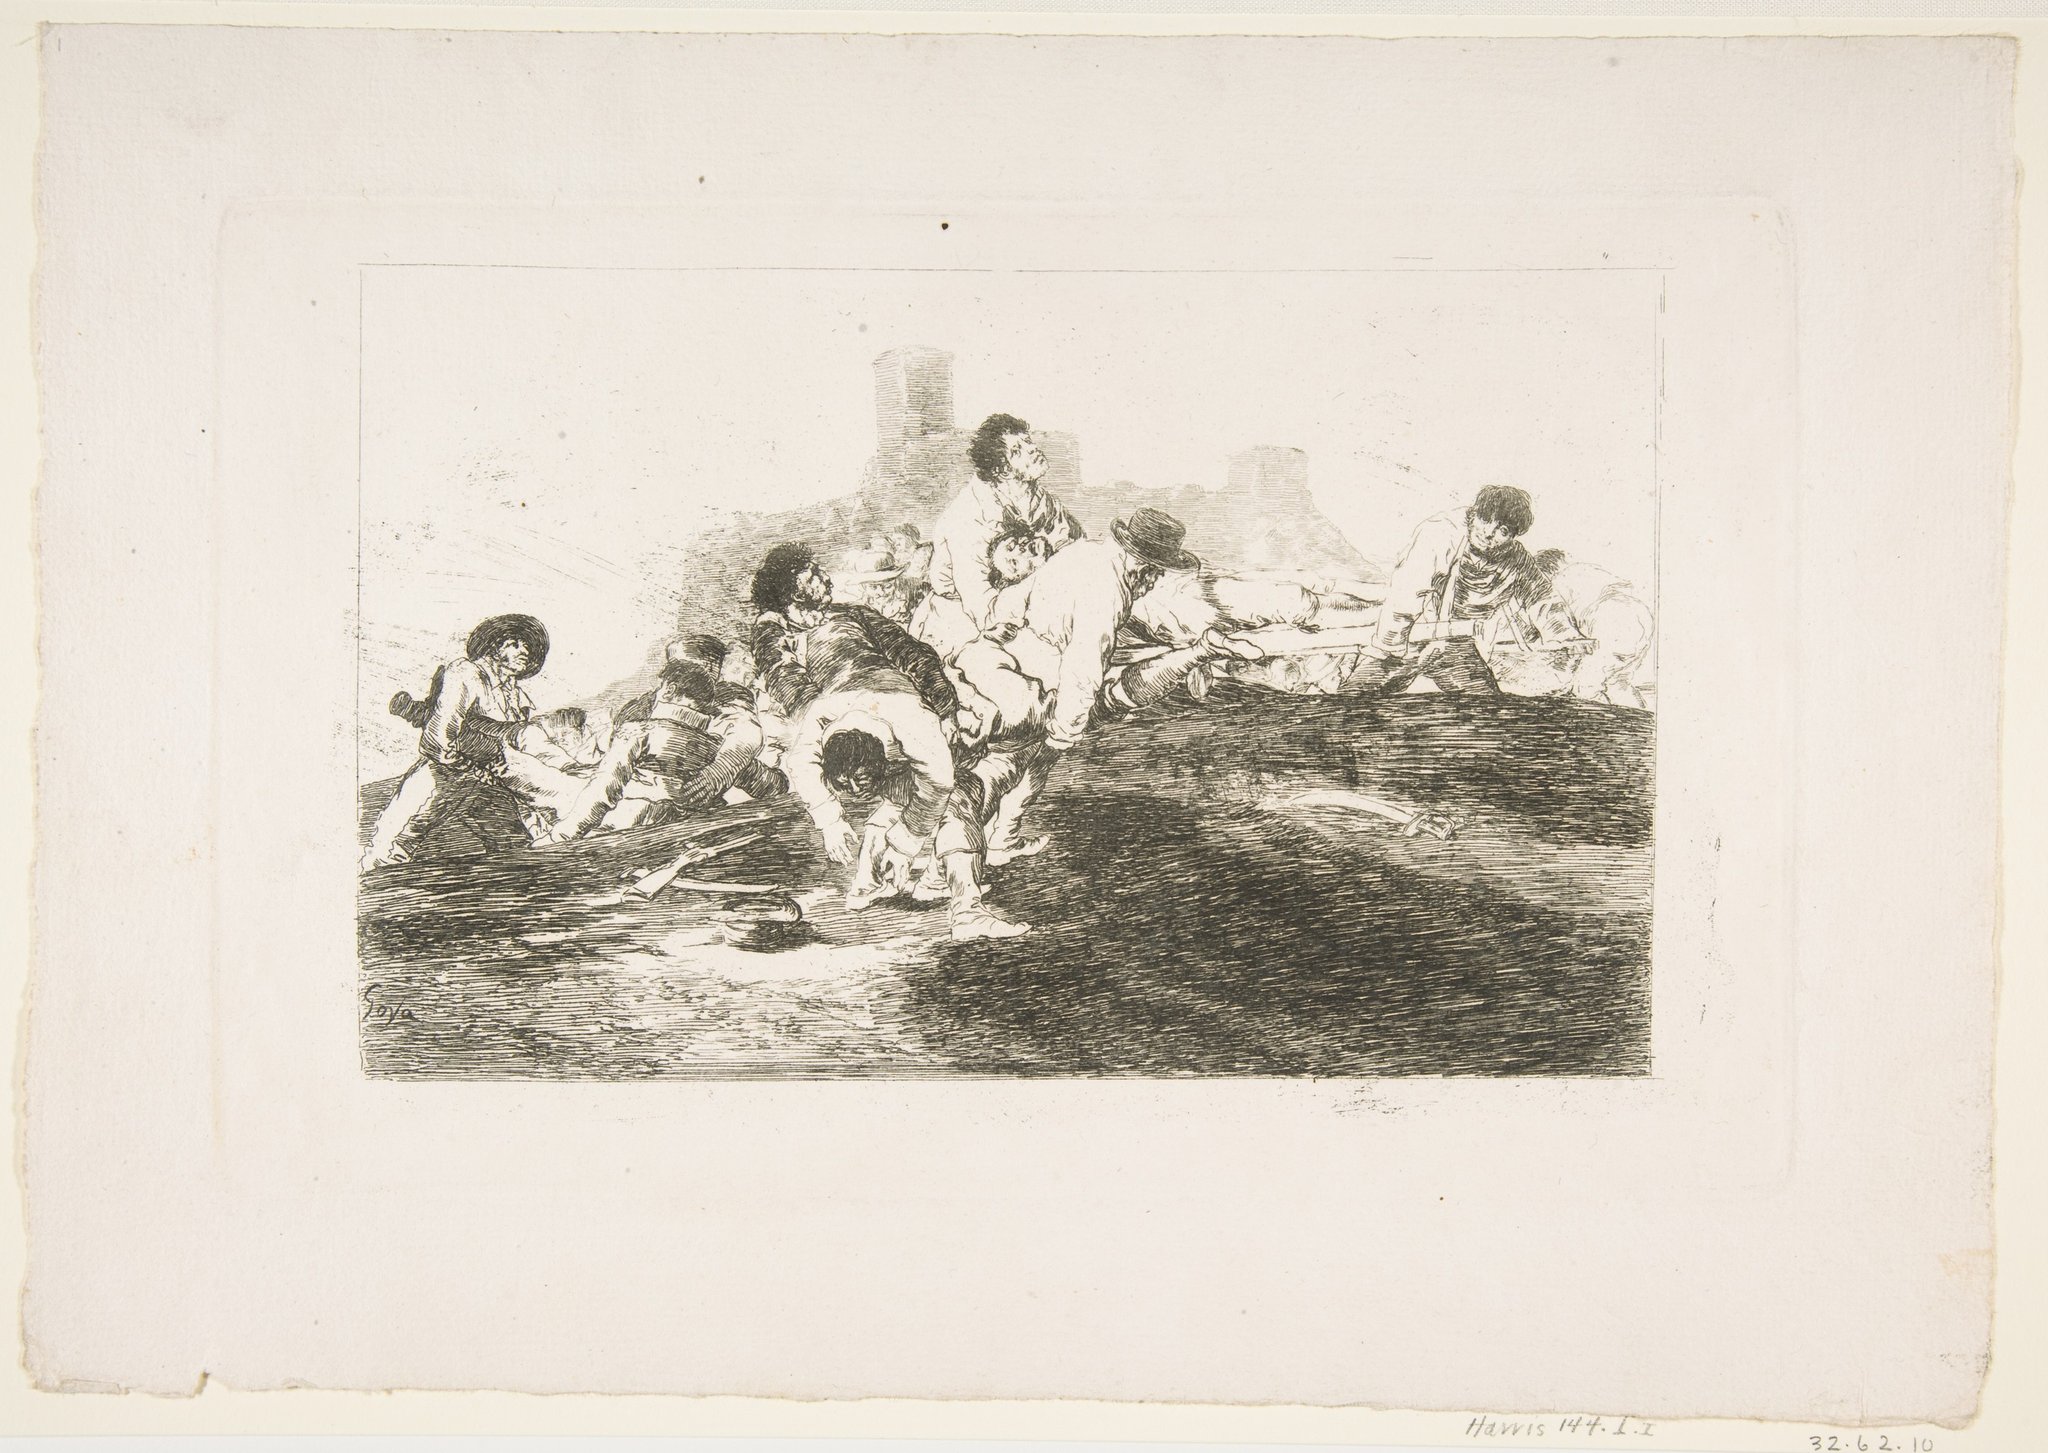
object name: print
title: Plate 24 from "The Disasters of War" (Los Desastres de la Guerra): 'They can still be of use' (Aun podrán servir)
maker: goya (francisco de goya y lucientes)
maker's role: artist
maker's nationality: spanish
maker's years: 1746-1828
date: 1810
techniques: etching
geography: spain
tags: men